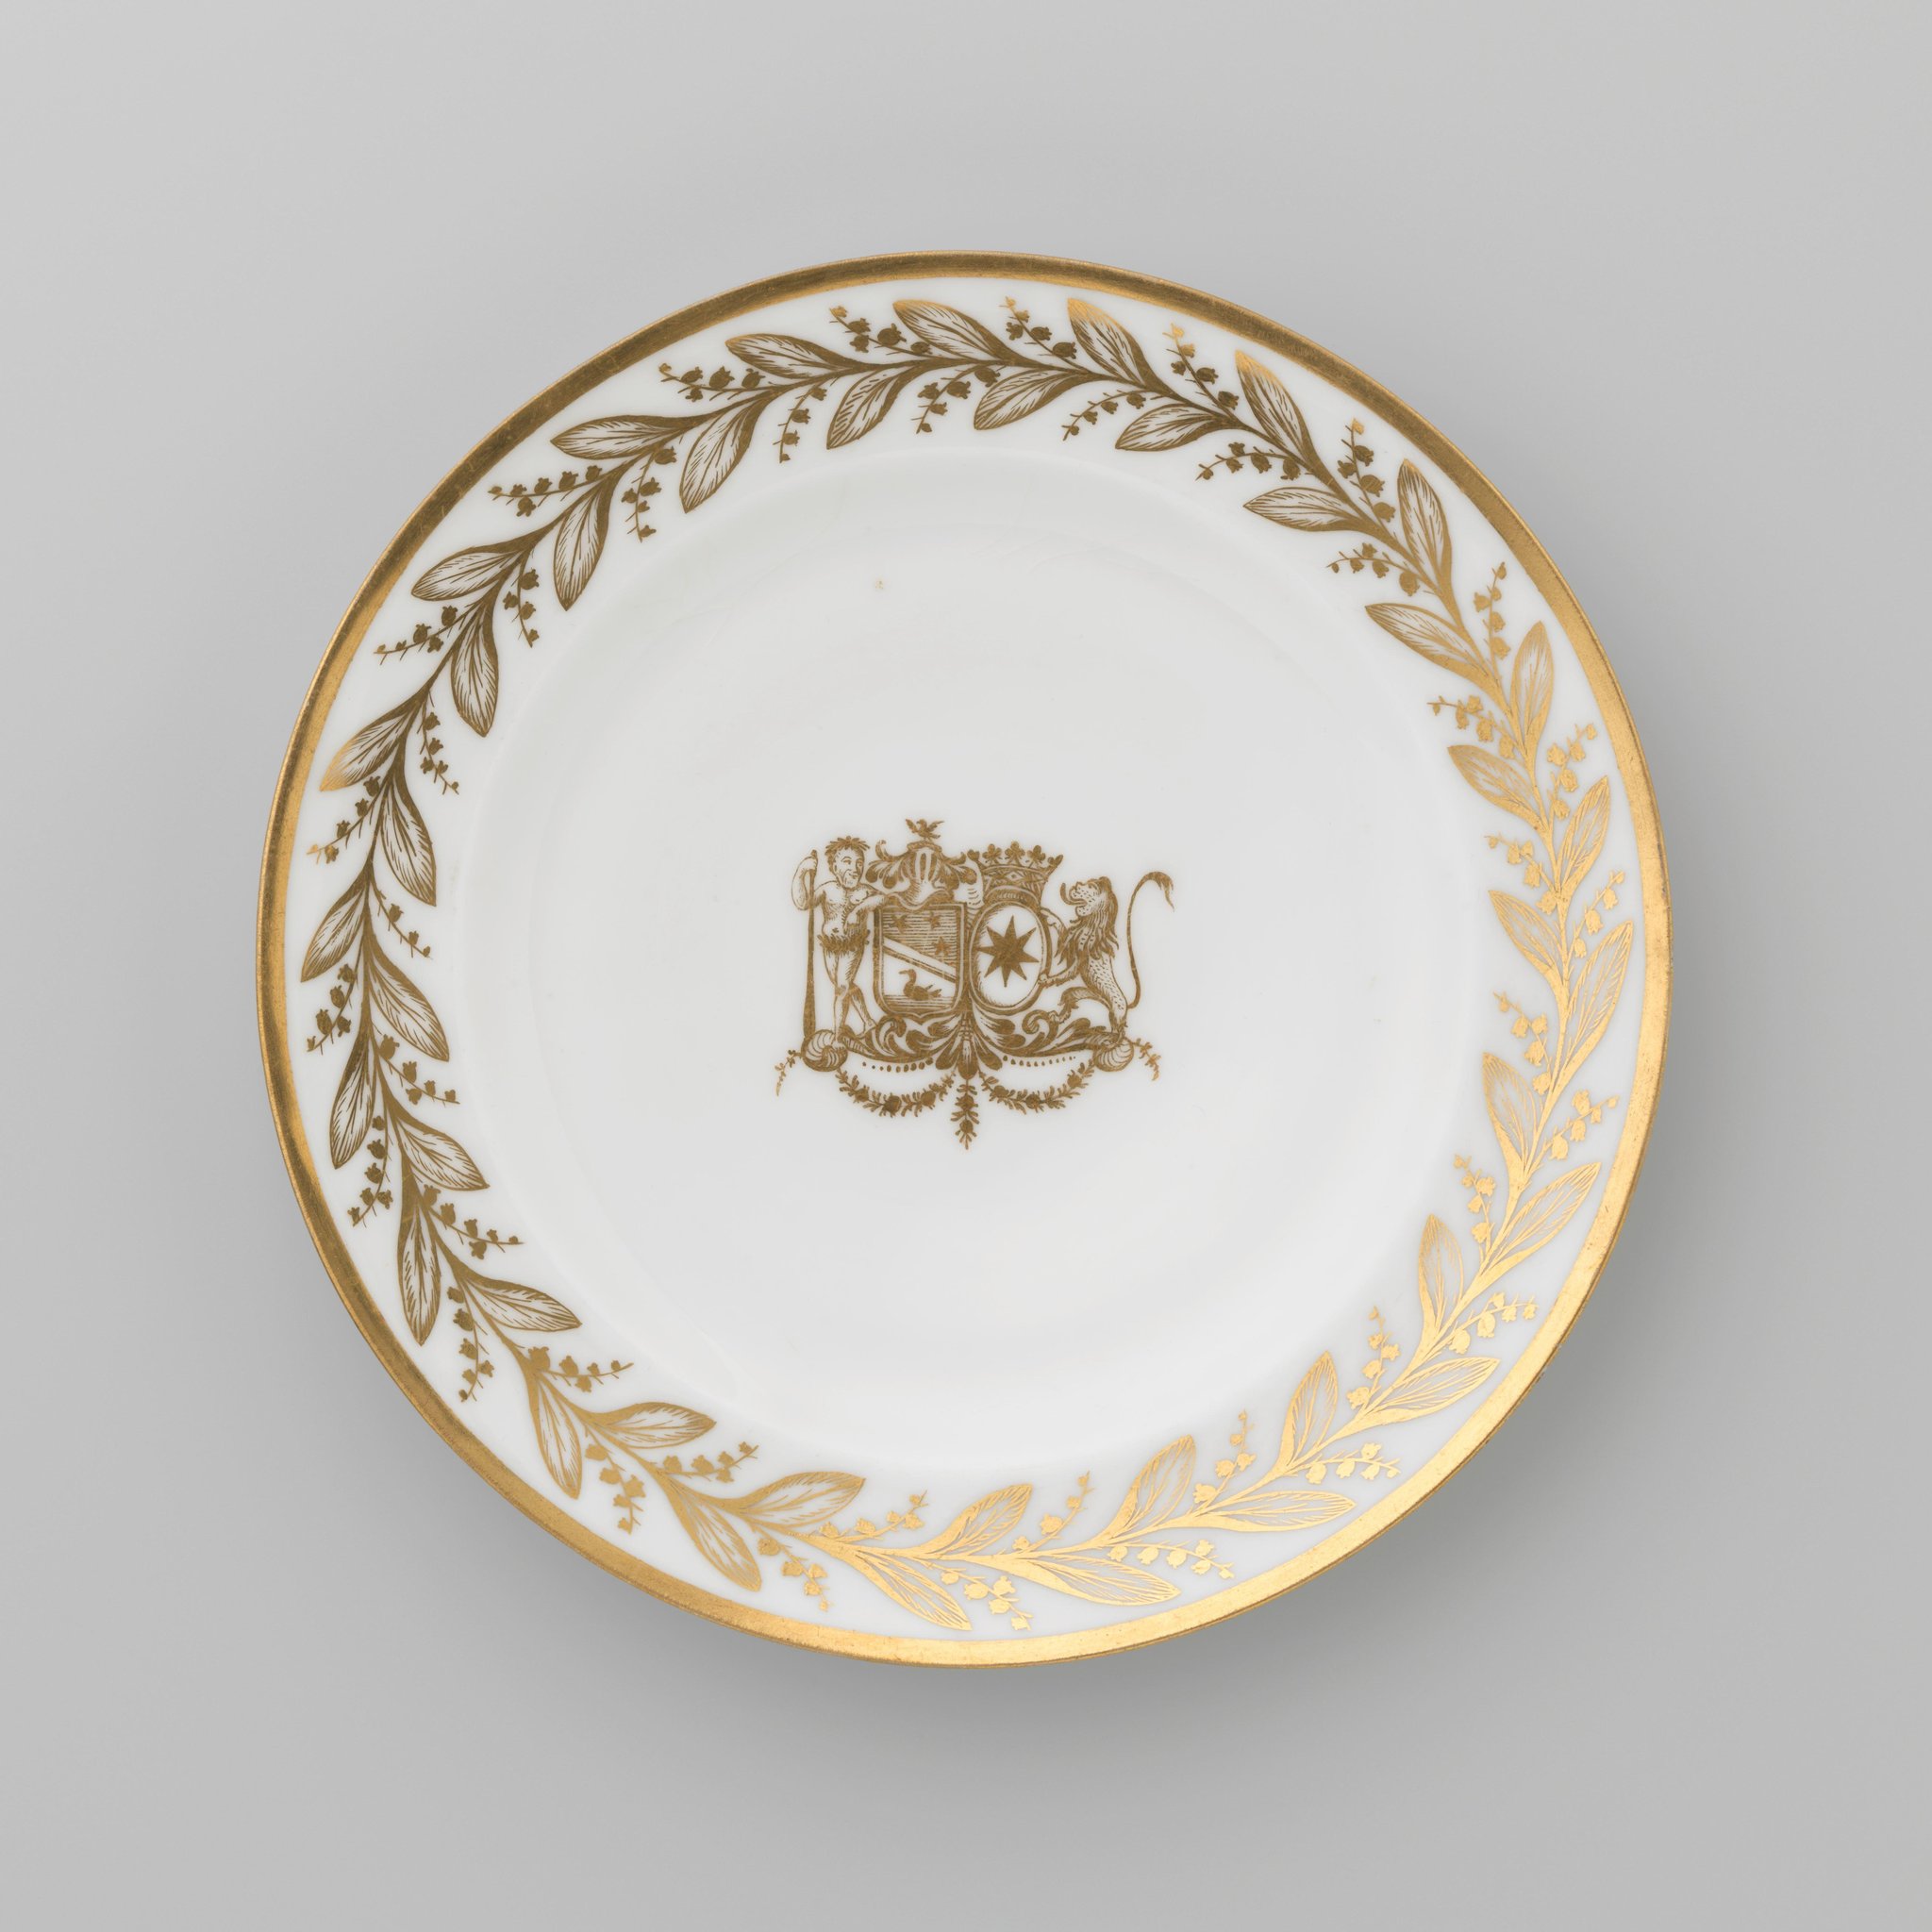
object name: service set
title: Plate with the coat of arms of Hendrik Peter Godfried Quack and Isabella Gertraud von Carnap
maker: Anonymous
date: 1790-1800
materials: glaze, gold, paint, porcelain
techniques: firing, forming, gilding, turning, vitrification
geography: paris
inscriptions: mark: ‘N’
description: Bord van porselein, beschilderd op het glazuur met goud. Op het plat het alliantiewapen van Hendrik Peter Godfried Quack en Isabella Gertraud von Carnap. De rand met een bloemrank en een gouden band. Drie proenen op de onderzijde. Gemerkt op de onderzijde met N.